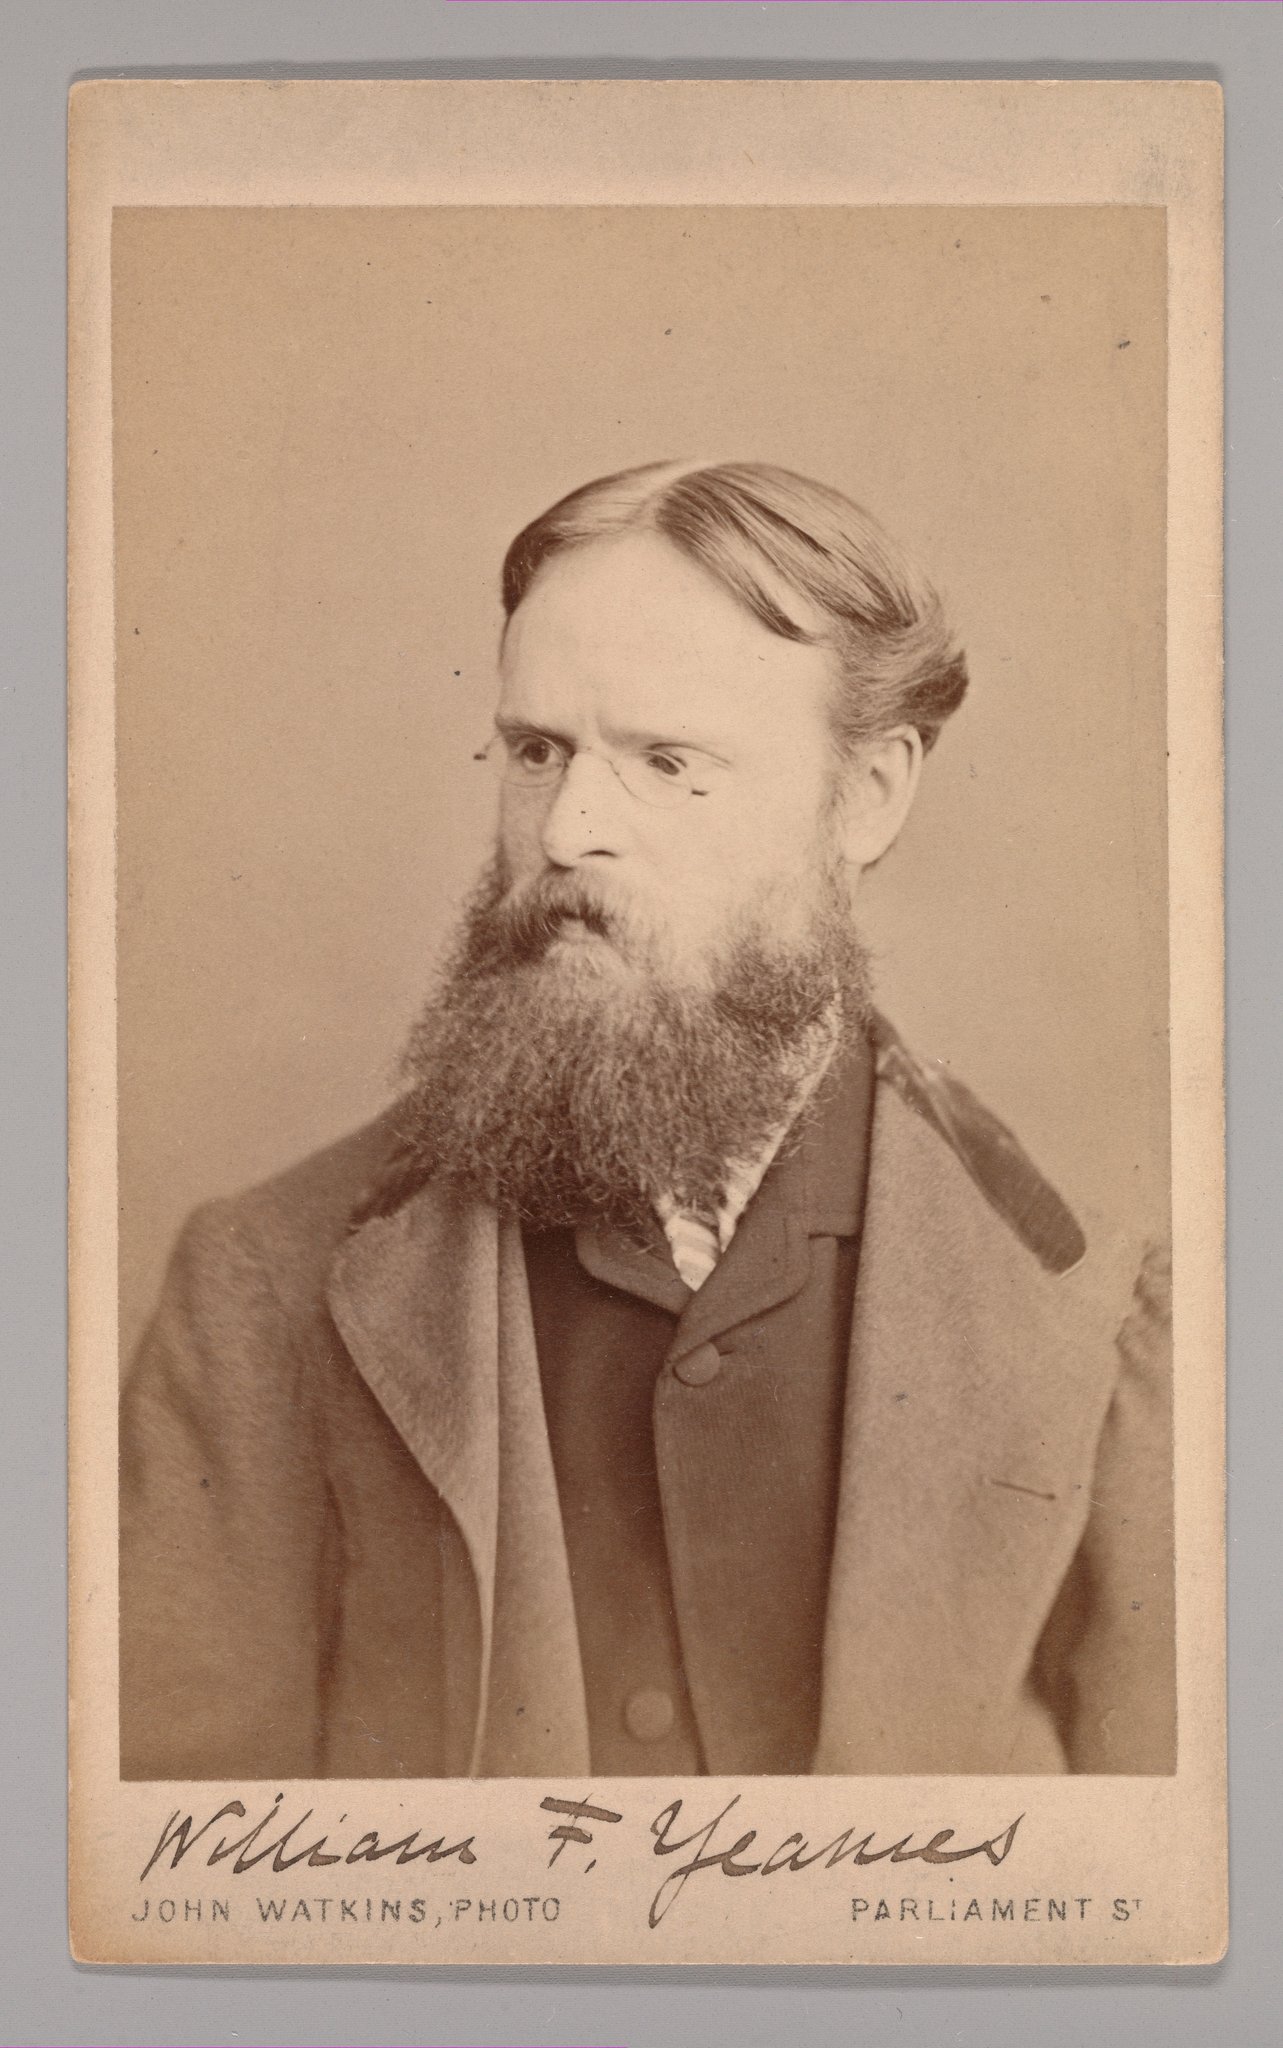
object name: carte de visite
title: [William Frederick Yeames]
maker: john and charles watkins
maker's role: photography studio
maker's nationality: british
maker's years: 1840-1875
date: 1860-1869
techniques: albumen silver print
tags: men,portraits